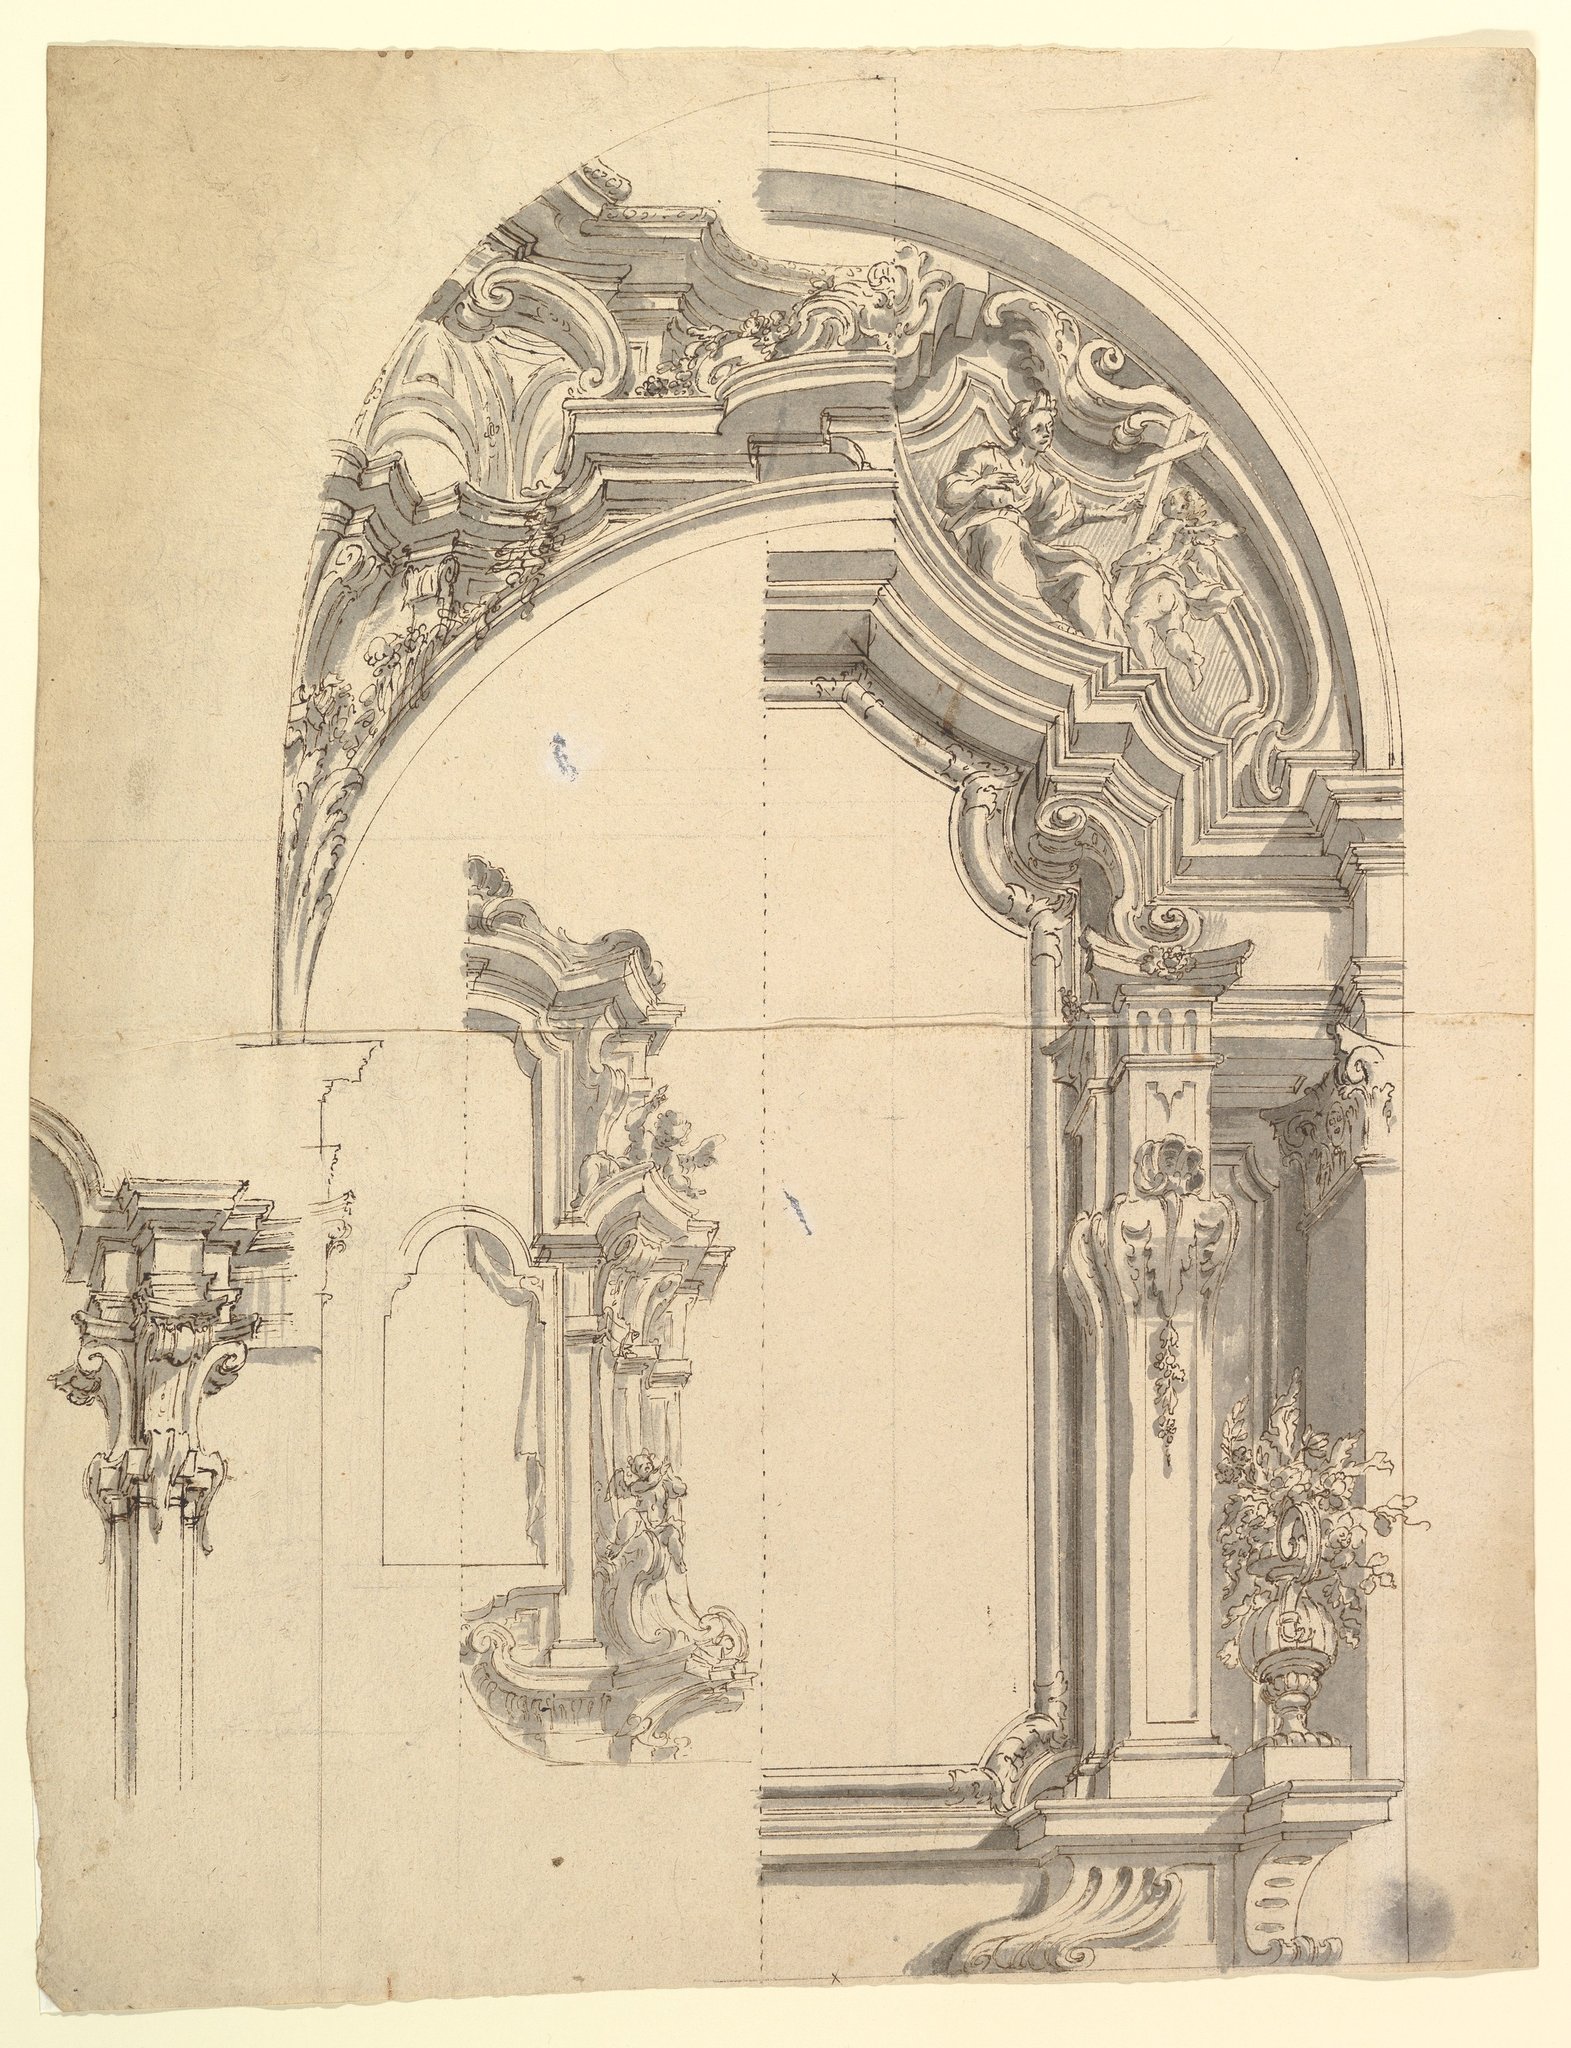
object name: drawing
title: Design for an Altar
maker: anonymous, italian, piedmontese, 18th century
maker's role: artist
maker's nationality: italian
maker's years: 1700-1800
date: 1700-1780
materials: graphite, ink, drawing material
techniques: brush, pen, wash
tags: altars